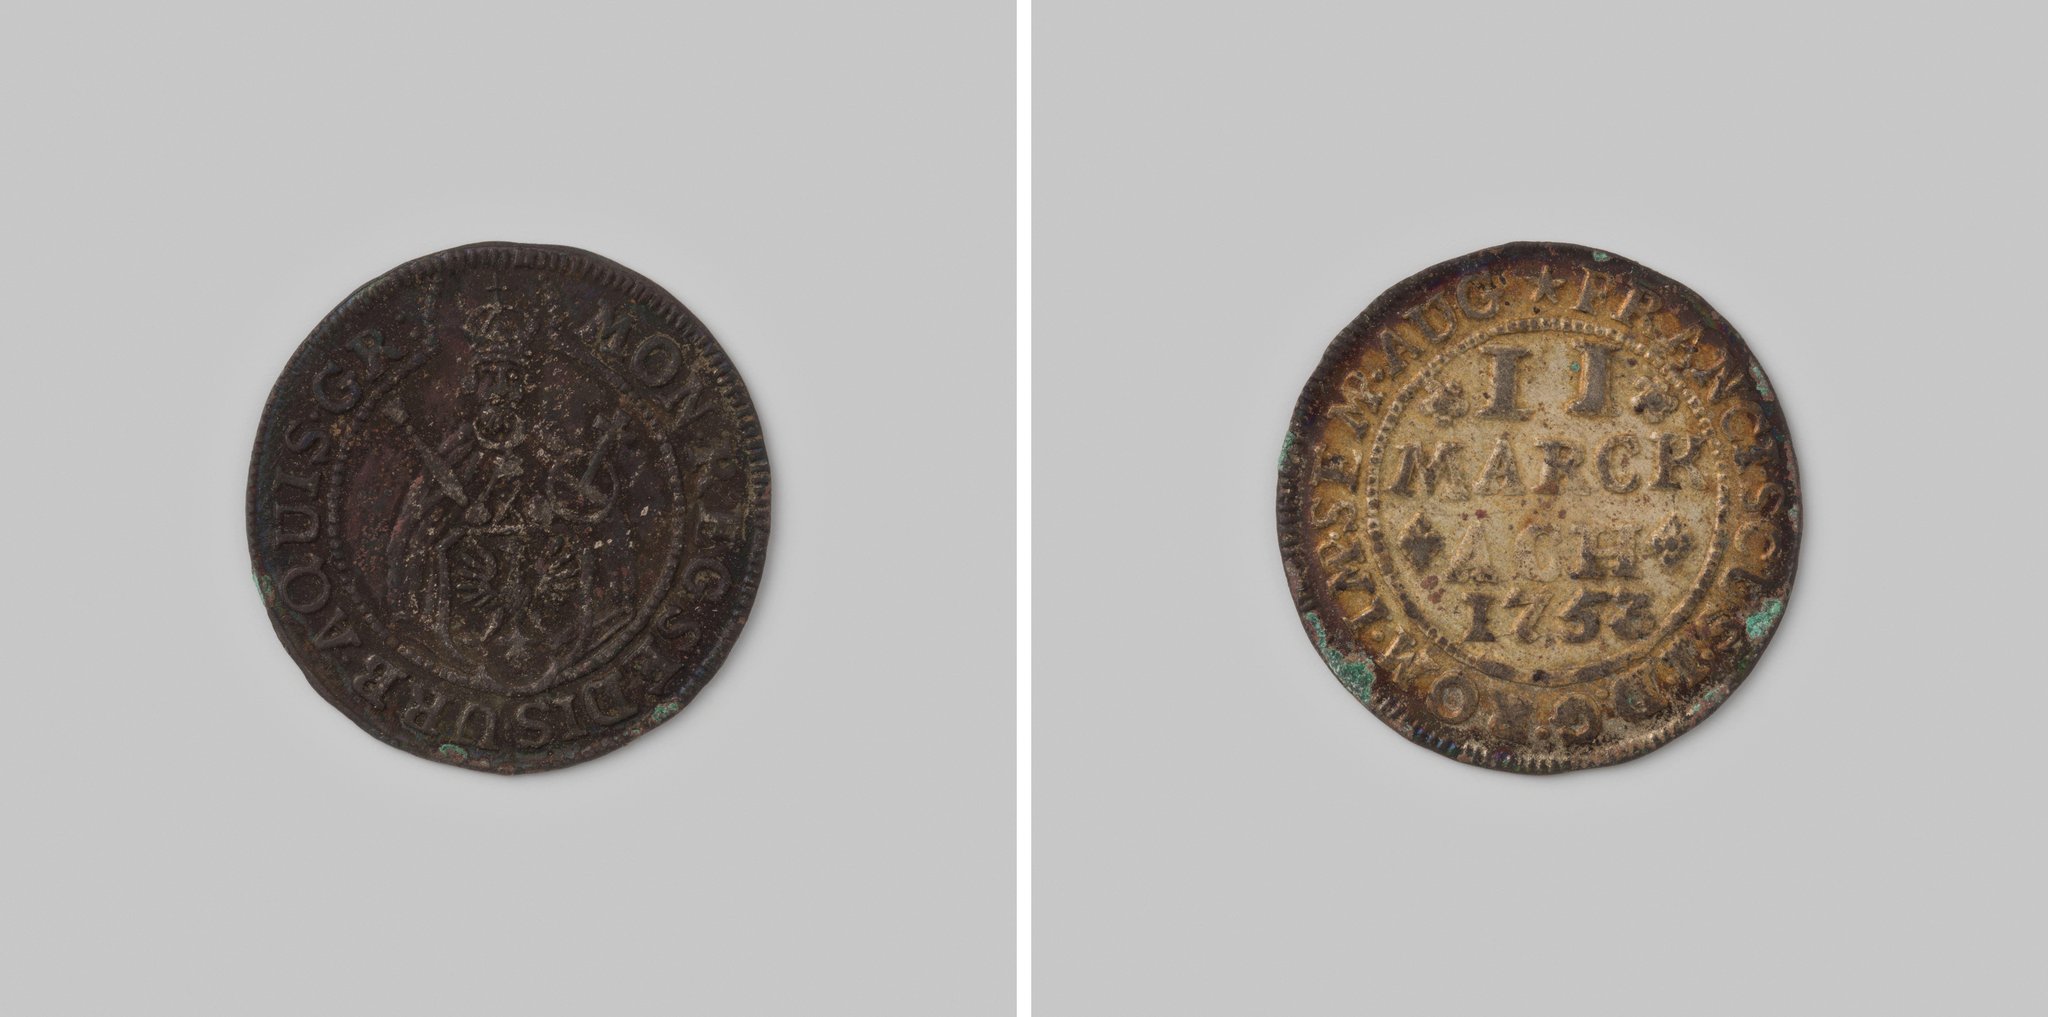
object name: coin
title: Rijksstad Aken op naam van keizer Frans I, 2 Marck, 1753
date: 1753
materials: silver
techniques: striking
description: Zilveren munt. Voorzijde: gekroonde Karel de Grote met rijksappel en scepter en voor zich het wapenschild van de stad. Keerzijde: waarde-aanduiding in drie regels, waaronder jaartal. Gladde rand.